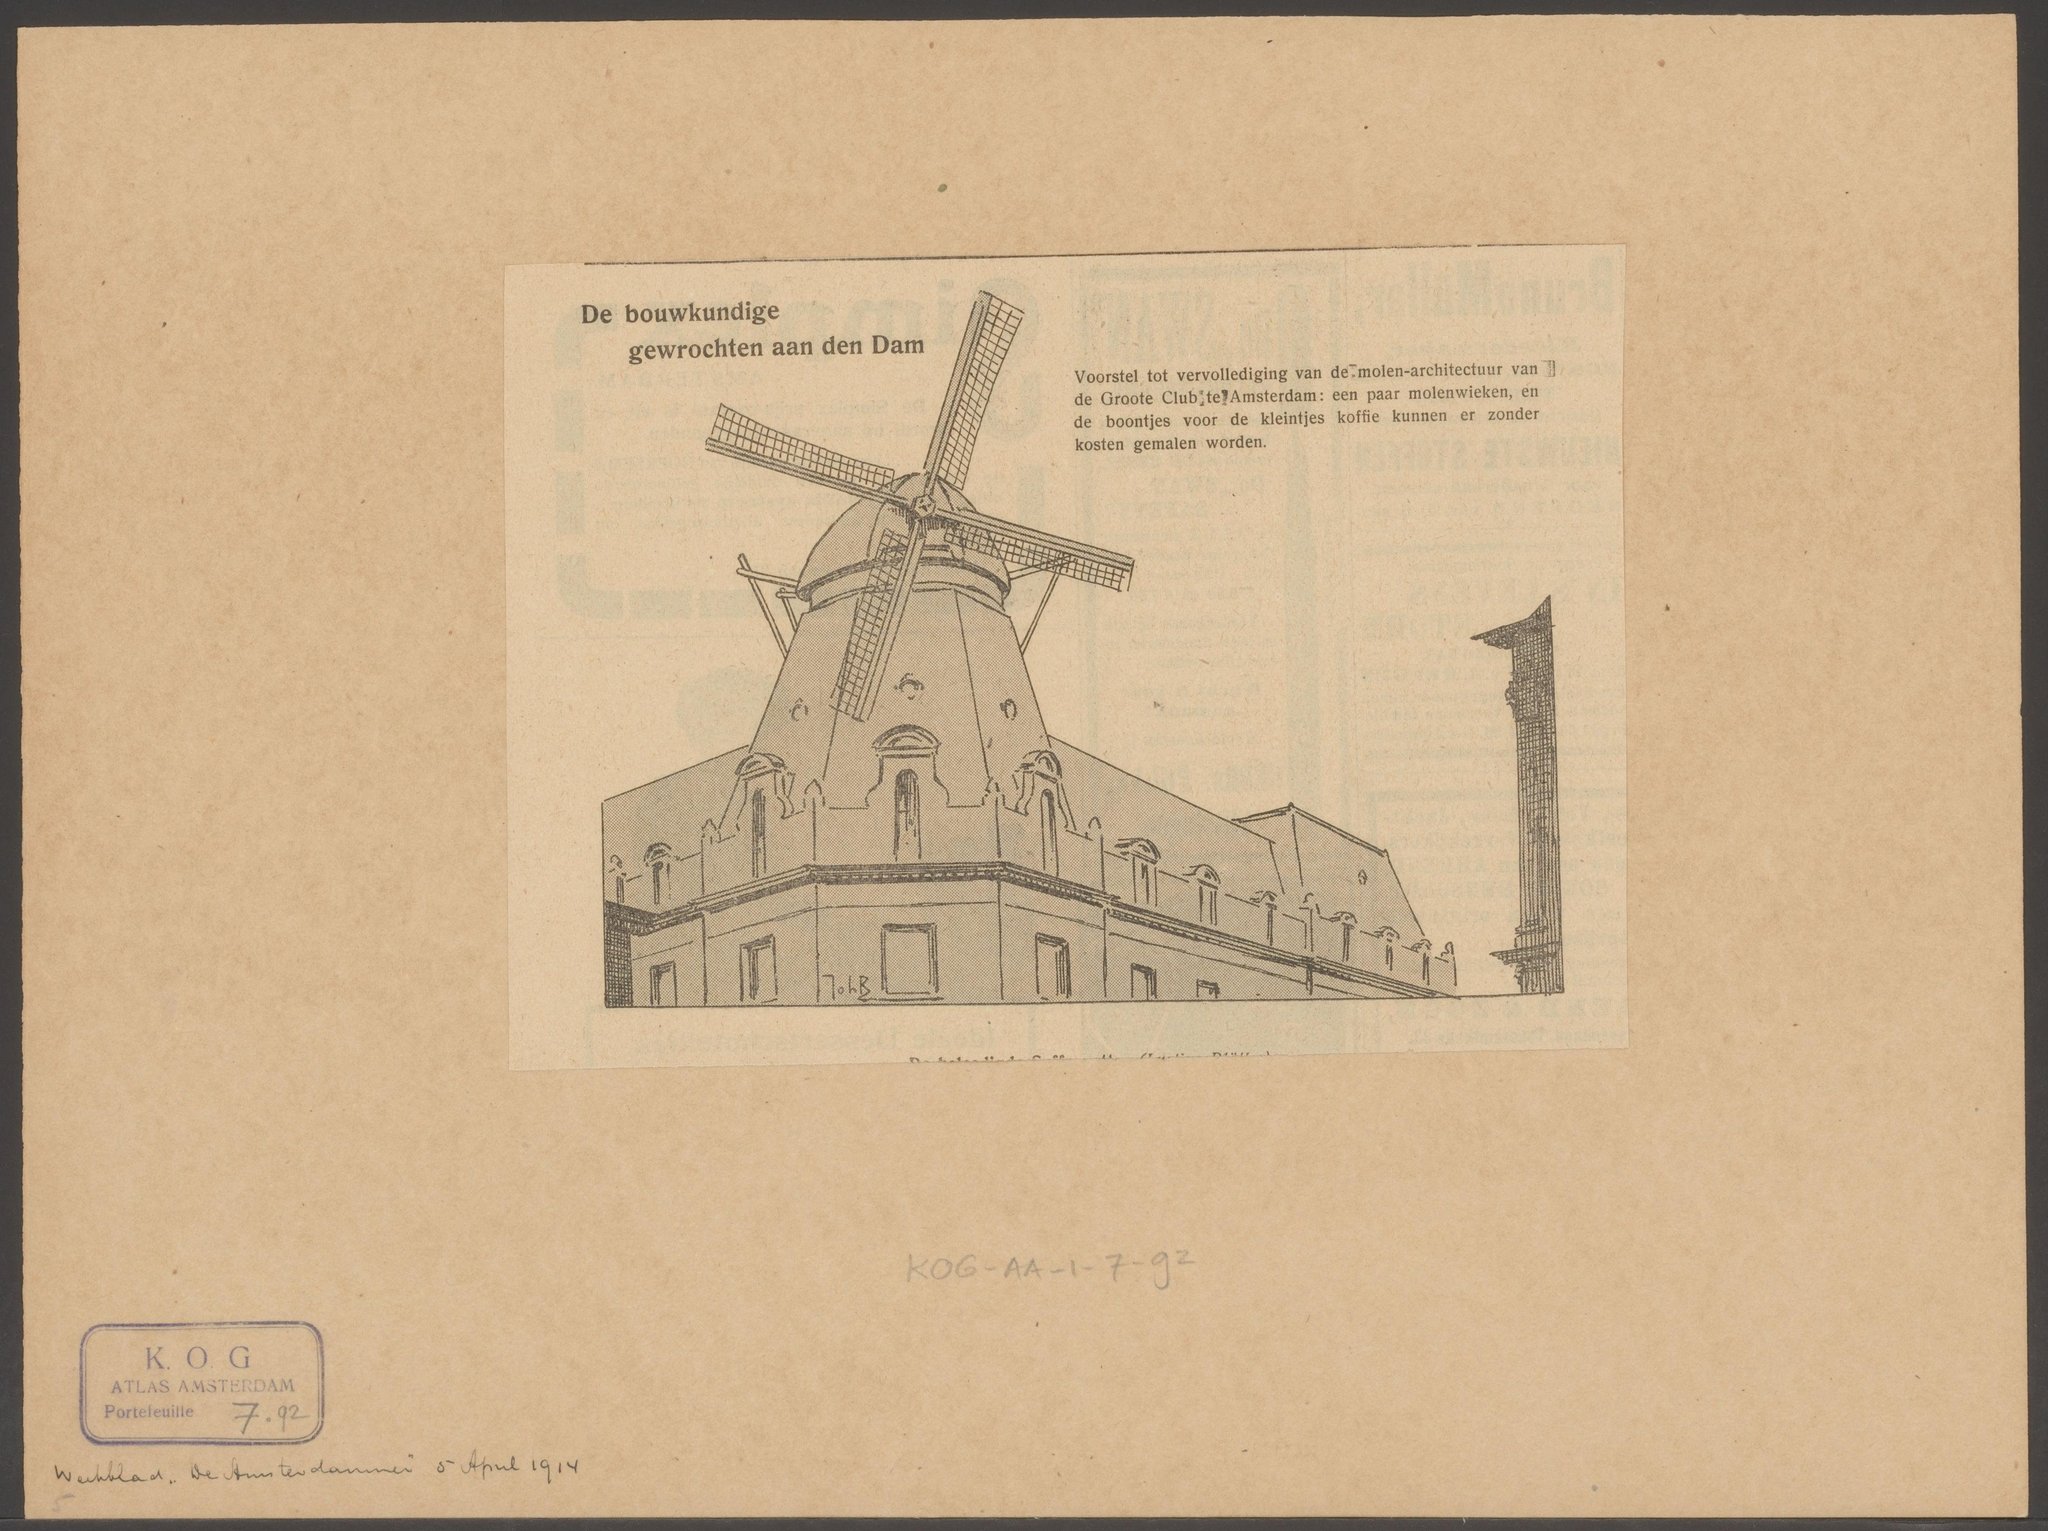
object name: photomechanical print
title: Gezicht op de Groote Club, met molen op de hoektoren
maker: Anonymous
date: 1914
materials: paper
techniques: letterpress printing, line block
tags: square, place, circus, etc., city-view in general; 'veduta', windmill in landscape, façade (of house or building)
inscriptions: collector's mark: ‘7’ Lugt 1641b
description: Fotomechanische afdruk uit: De Amsterdammer (1914), 5 april 1914.